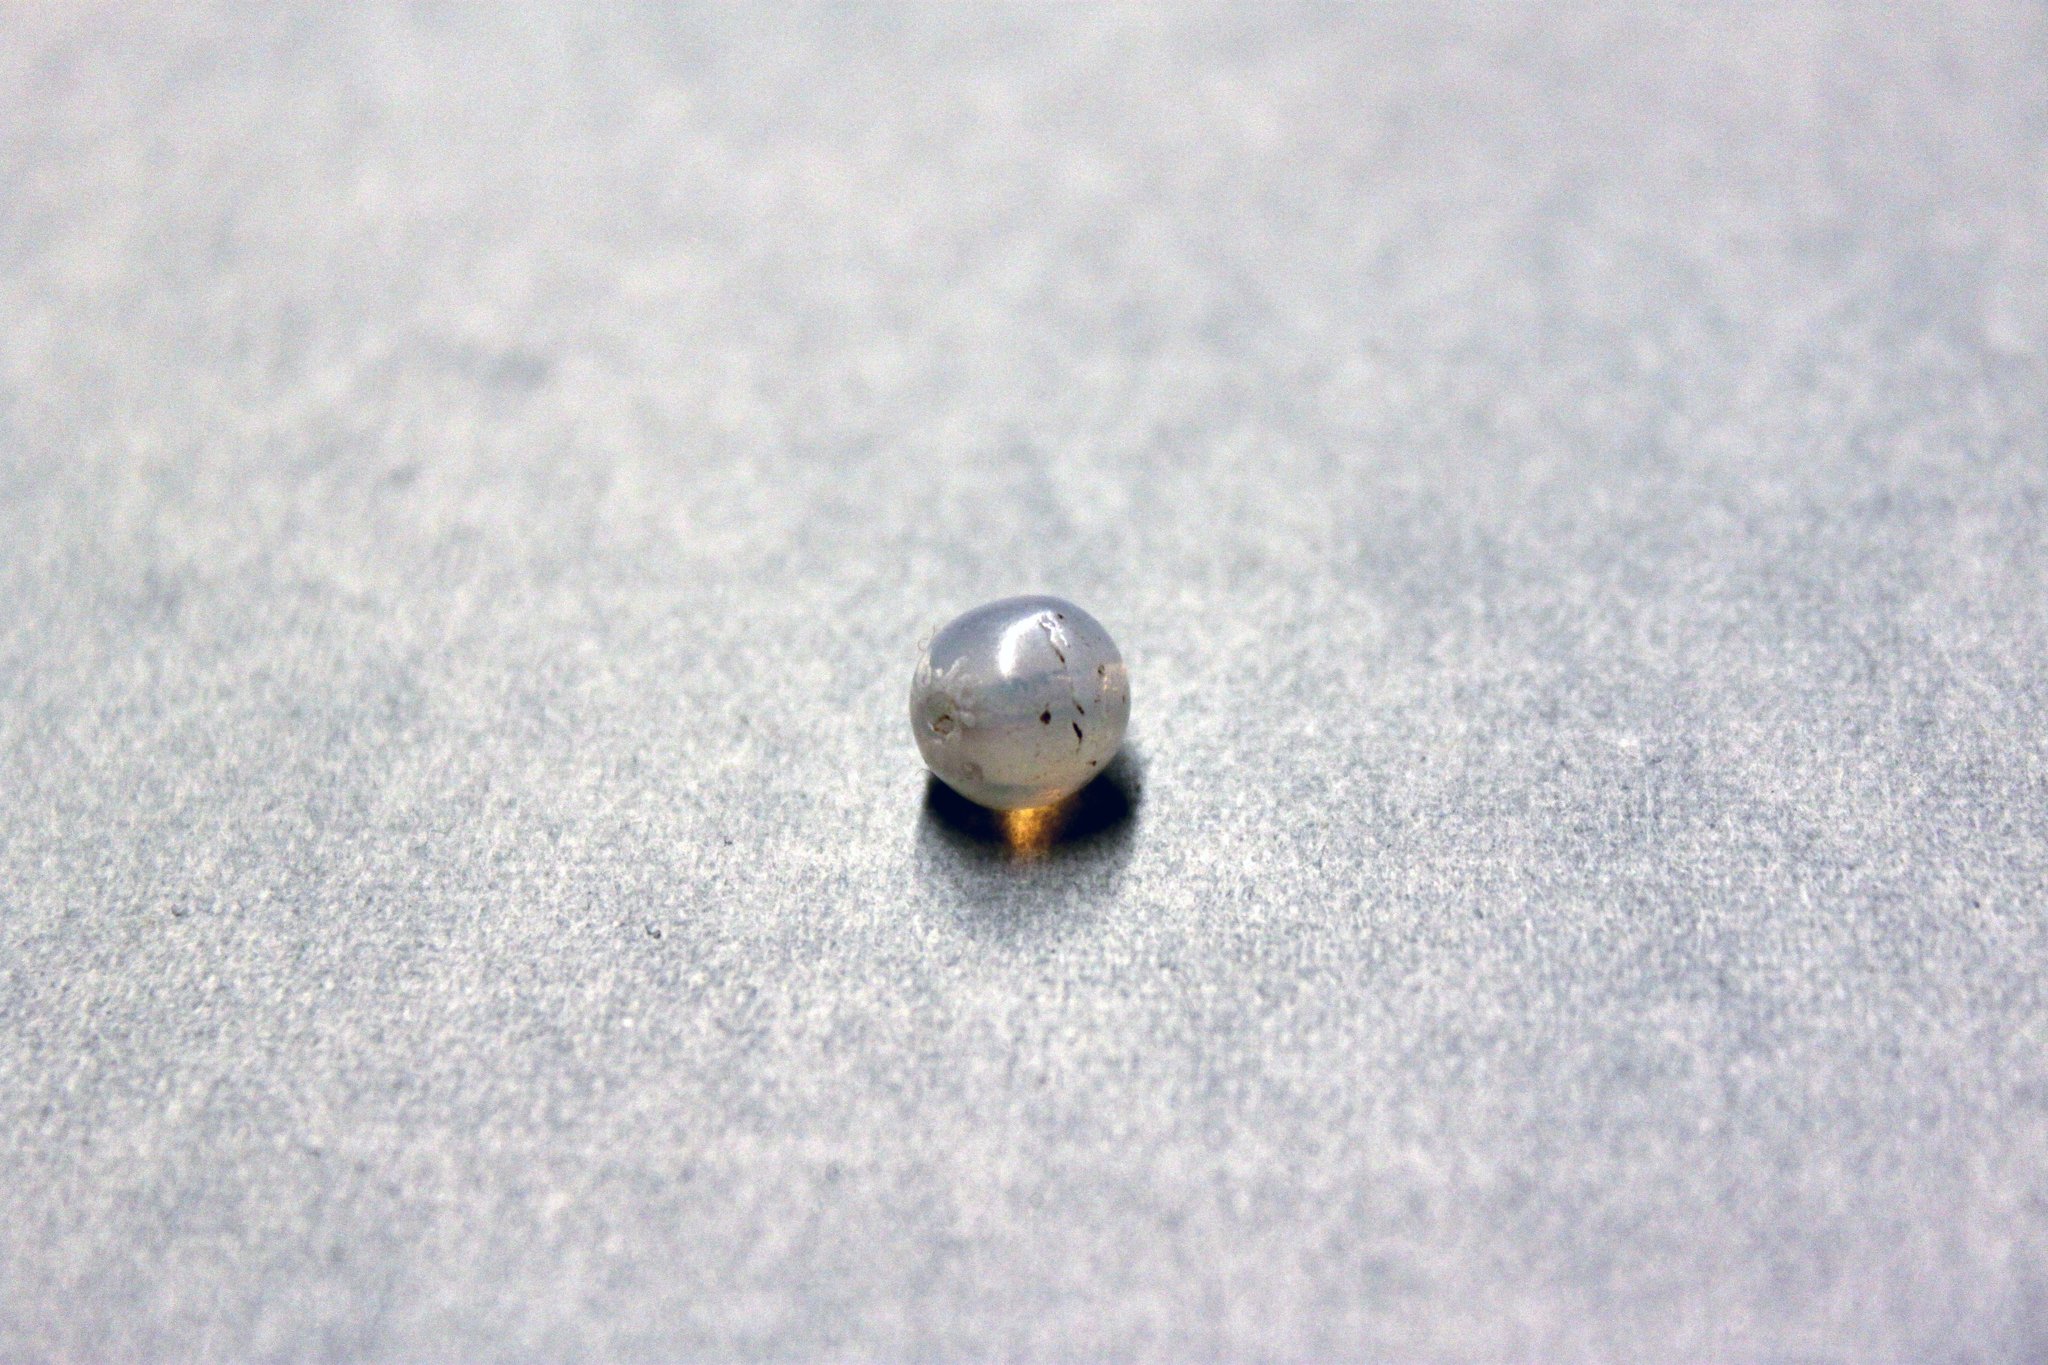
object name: bead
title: Beads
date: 701-1300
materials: glass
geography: iran